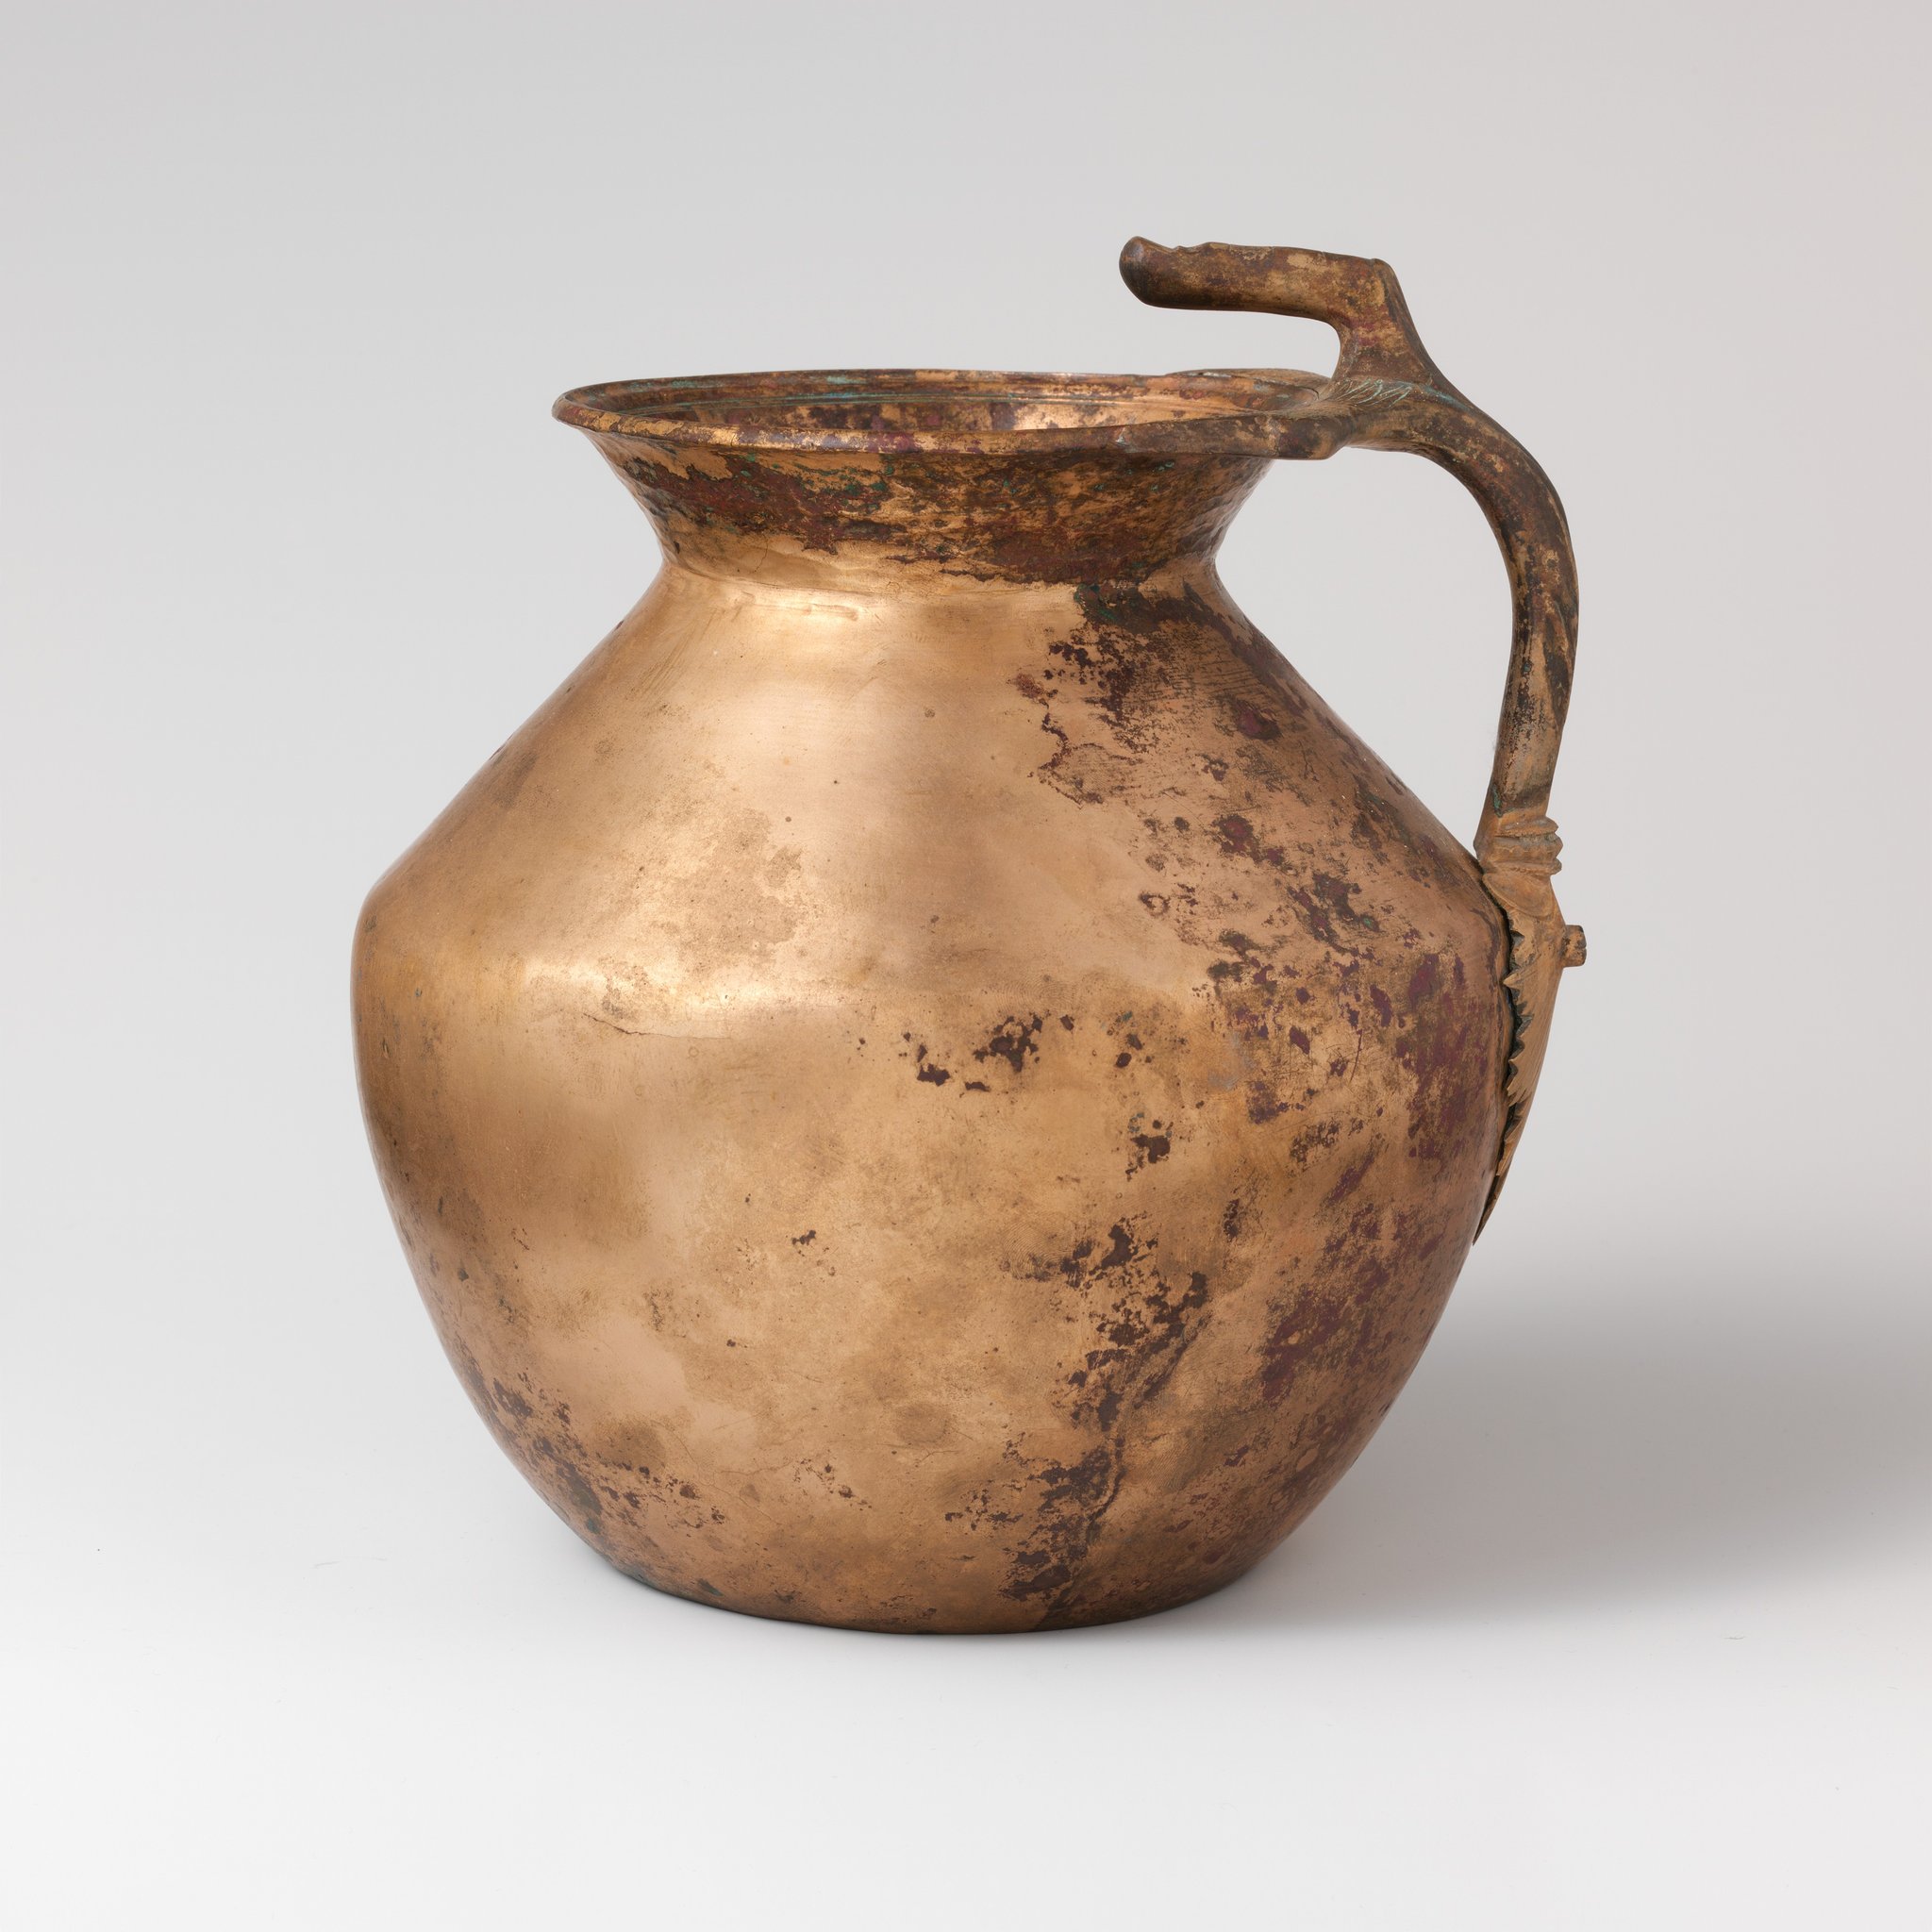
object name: jug with handle of bird's head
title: Bronze jug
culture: roman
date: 1-100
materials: bronze